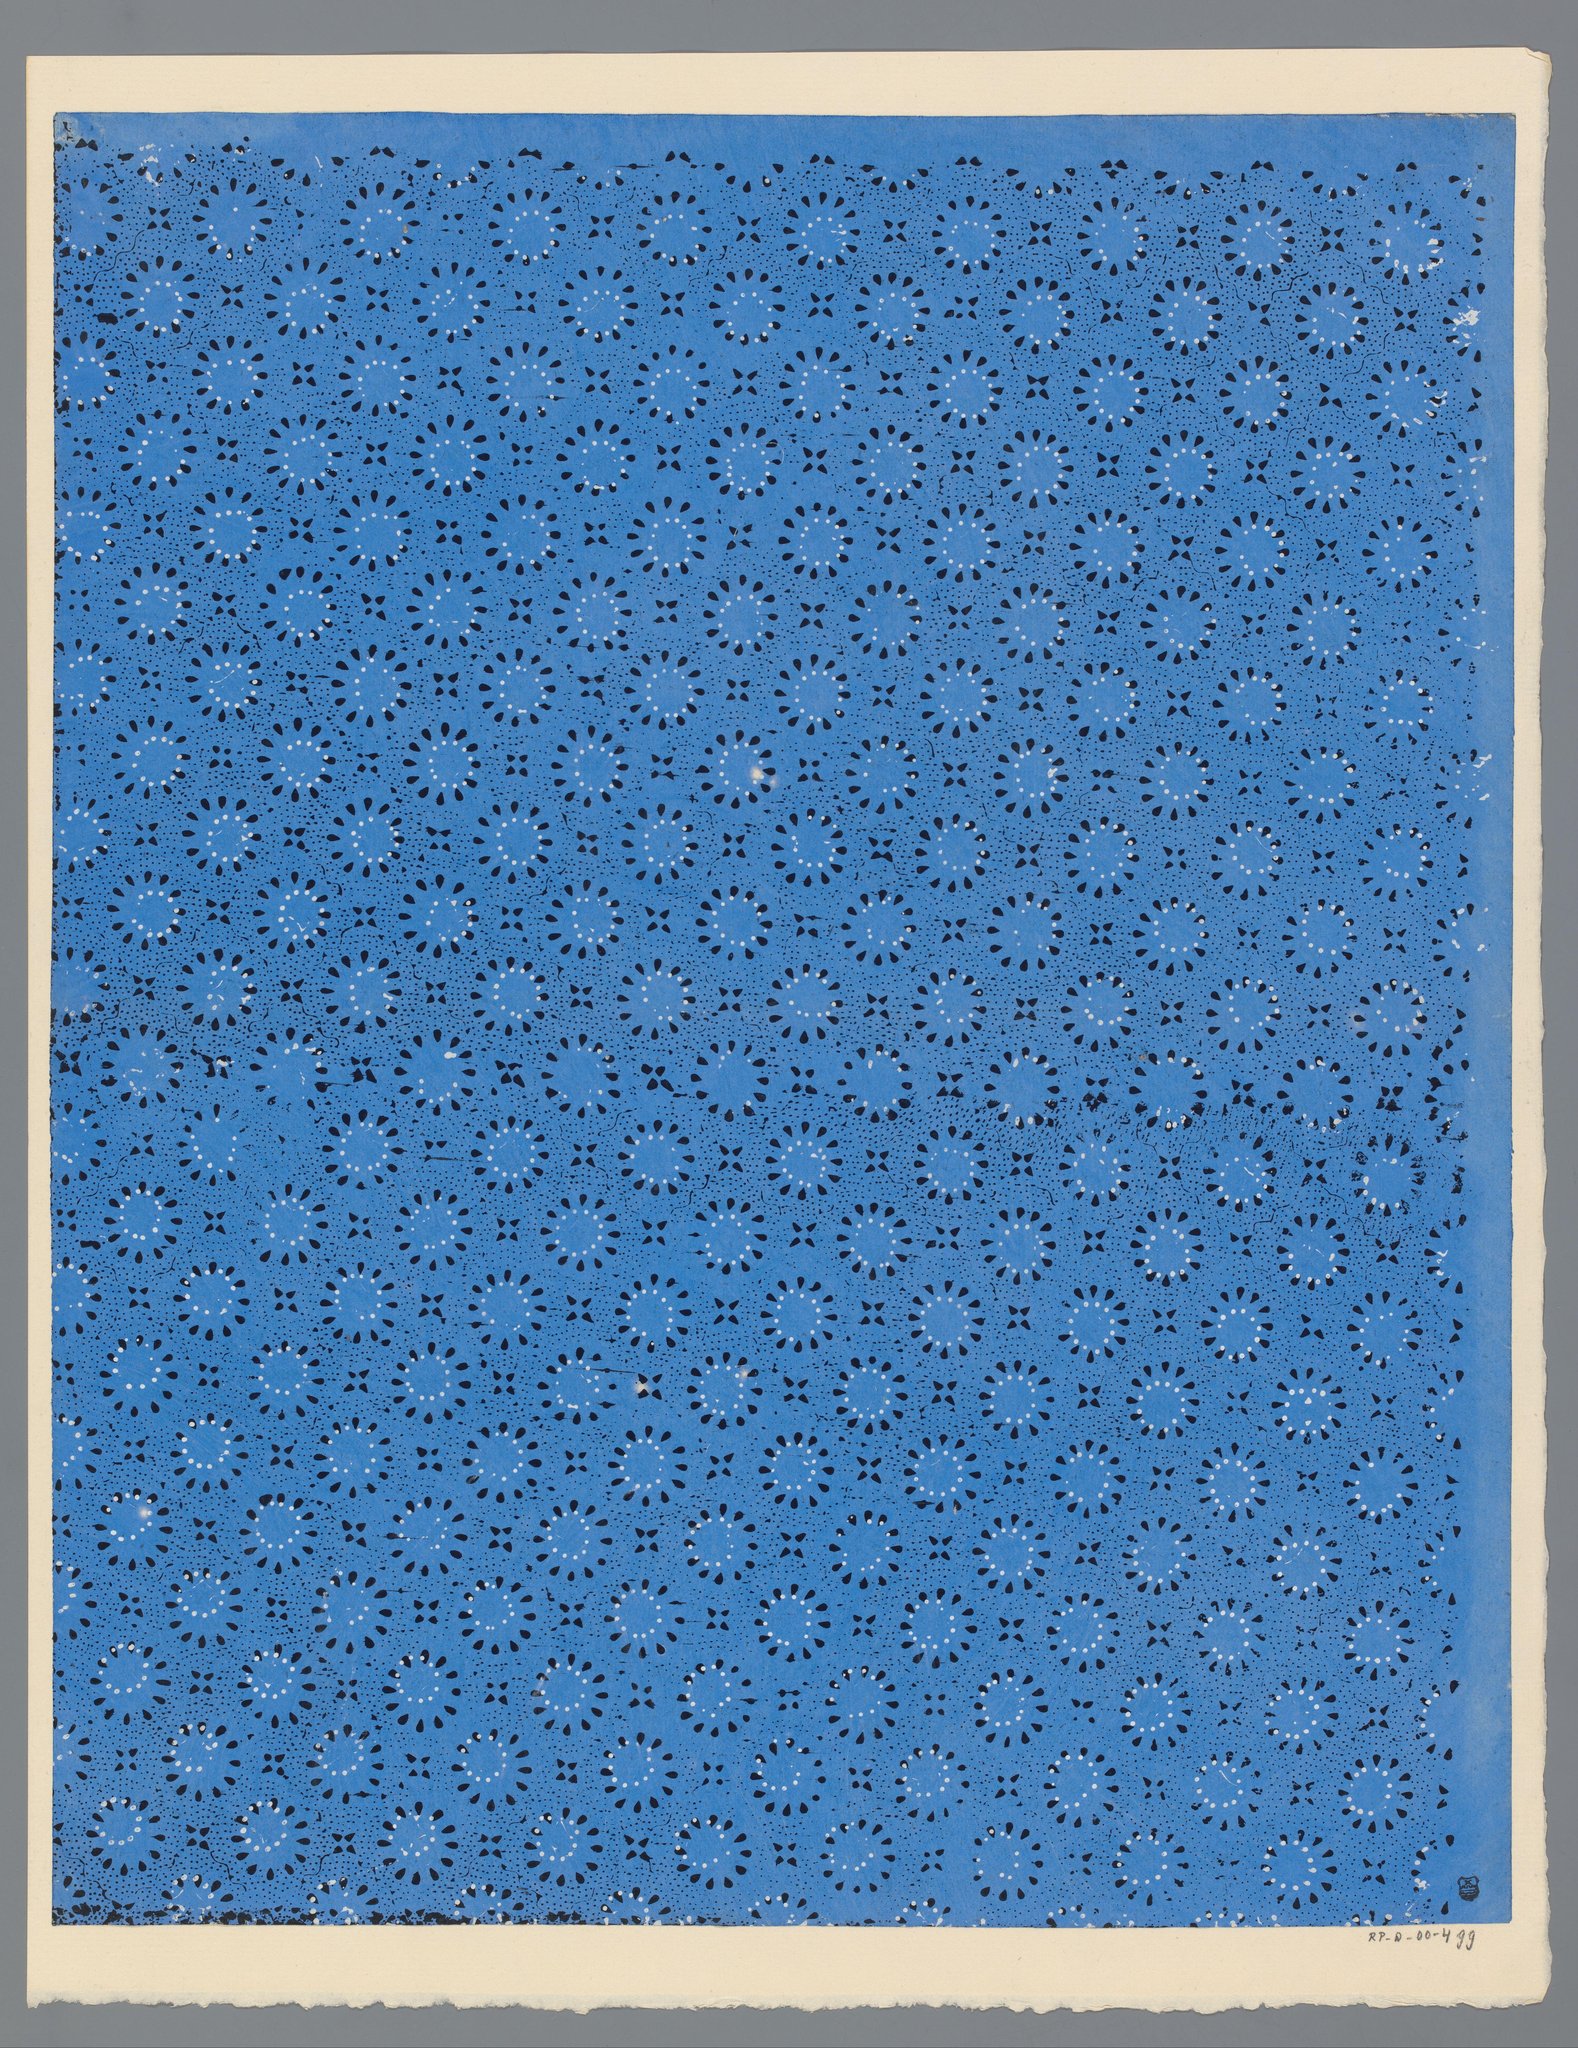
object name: printed paper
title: Blad met strooipatroon van zonmotief tussen punten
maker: Anonymous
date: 1800-1900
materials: paper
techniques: printing block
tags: fantasy ornament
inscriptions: collector's mark: Lugt 2760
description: Blad met strooipatroon van een zonmotief tussen punten.